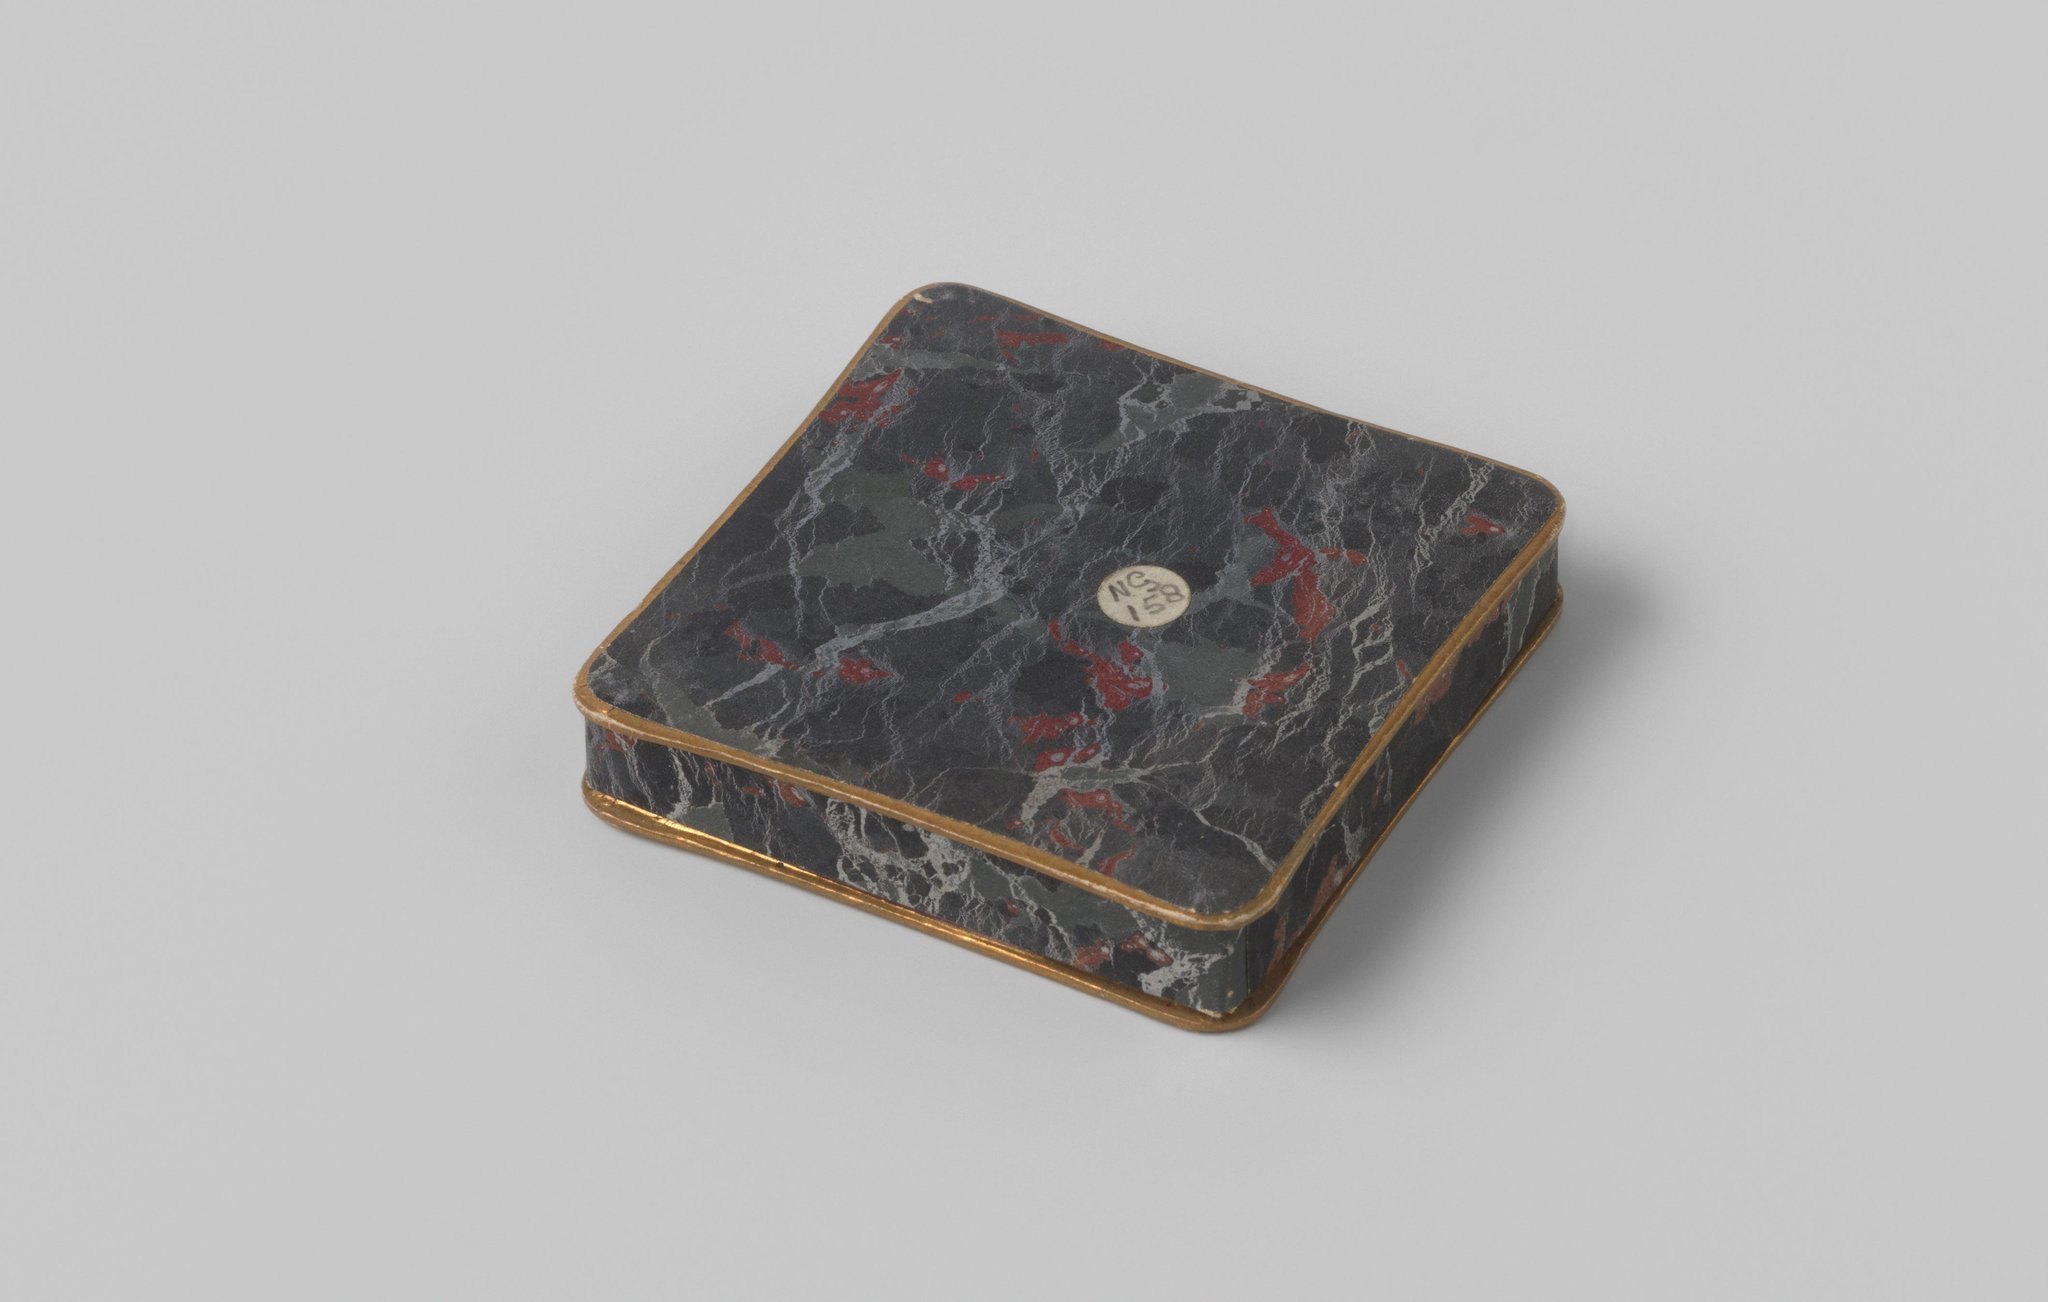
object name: box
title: Doos behorend bij een bronzen historiepenning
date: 1909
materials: cardboard, velvet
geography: utrecht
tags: den helder, leiden, utrecht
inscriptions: inscription: ‘PETRUS JOHANNES BLOK / TOON DUPUIS’, inscription: ‘AAN DEN / HOOGLEERAAR / EN DEN VRIEND / GRONINGEN - LEIDEN / 1884-26 SEPT.-1909 / BEGEER’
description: Vierkante kartonnen doosje met gouden randen. Aan de binnenkant rood fluweel waarin met gouden staat: 'Koninklijke Utrechtsche Fabriek van Zilverwerken van C.J. Begeer, Oudegracht, UTRECHT.